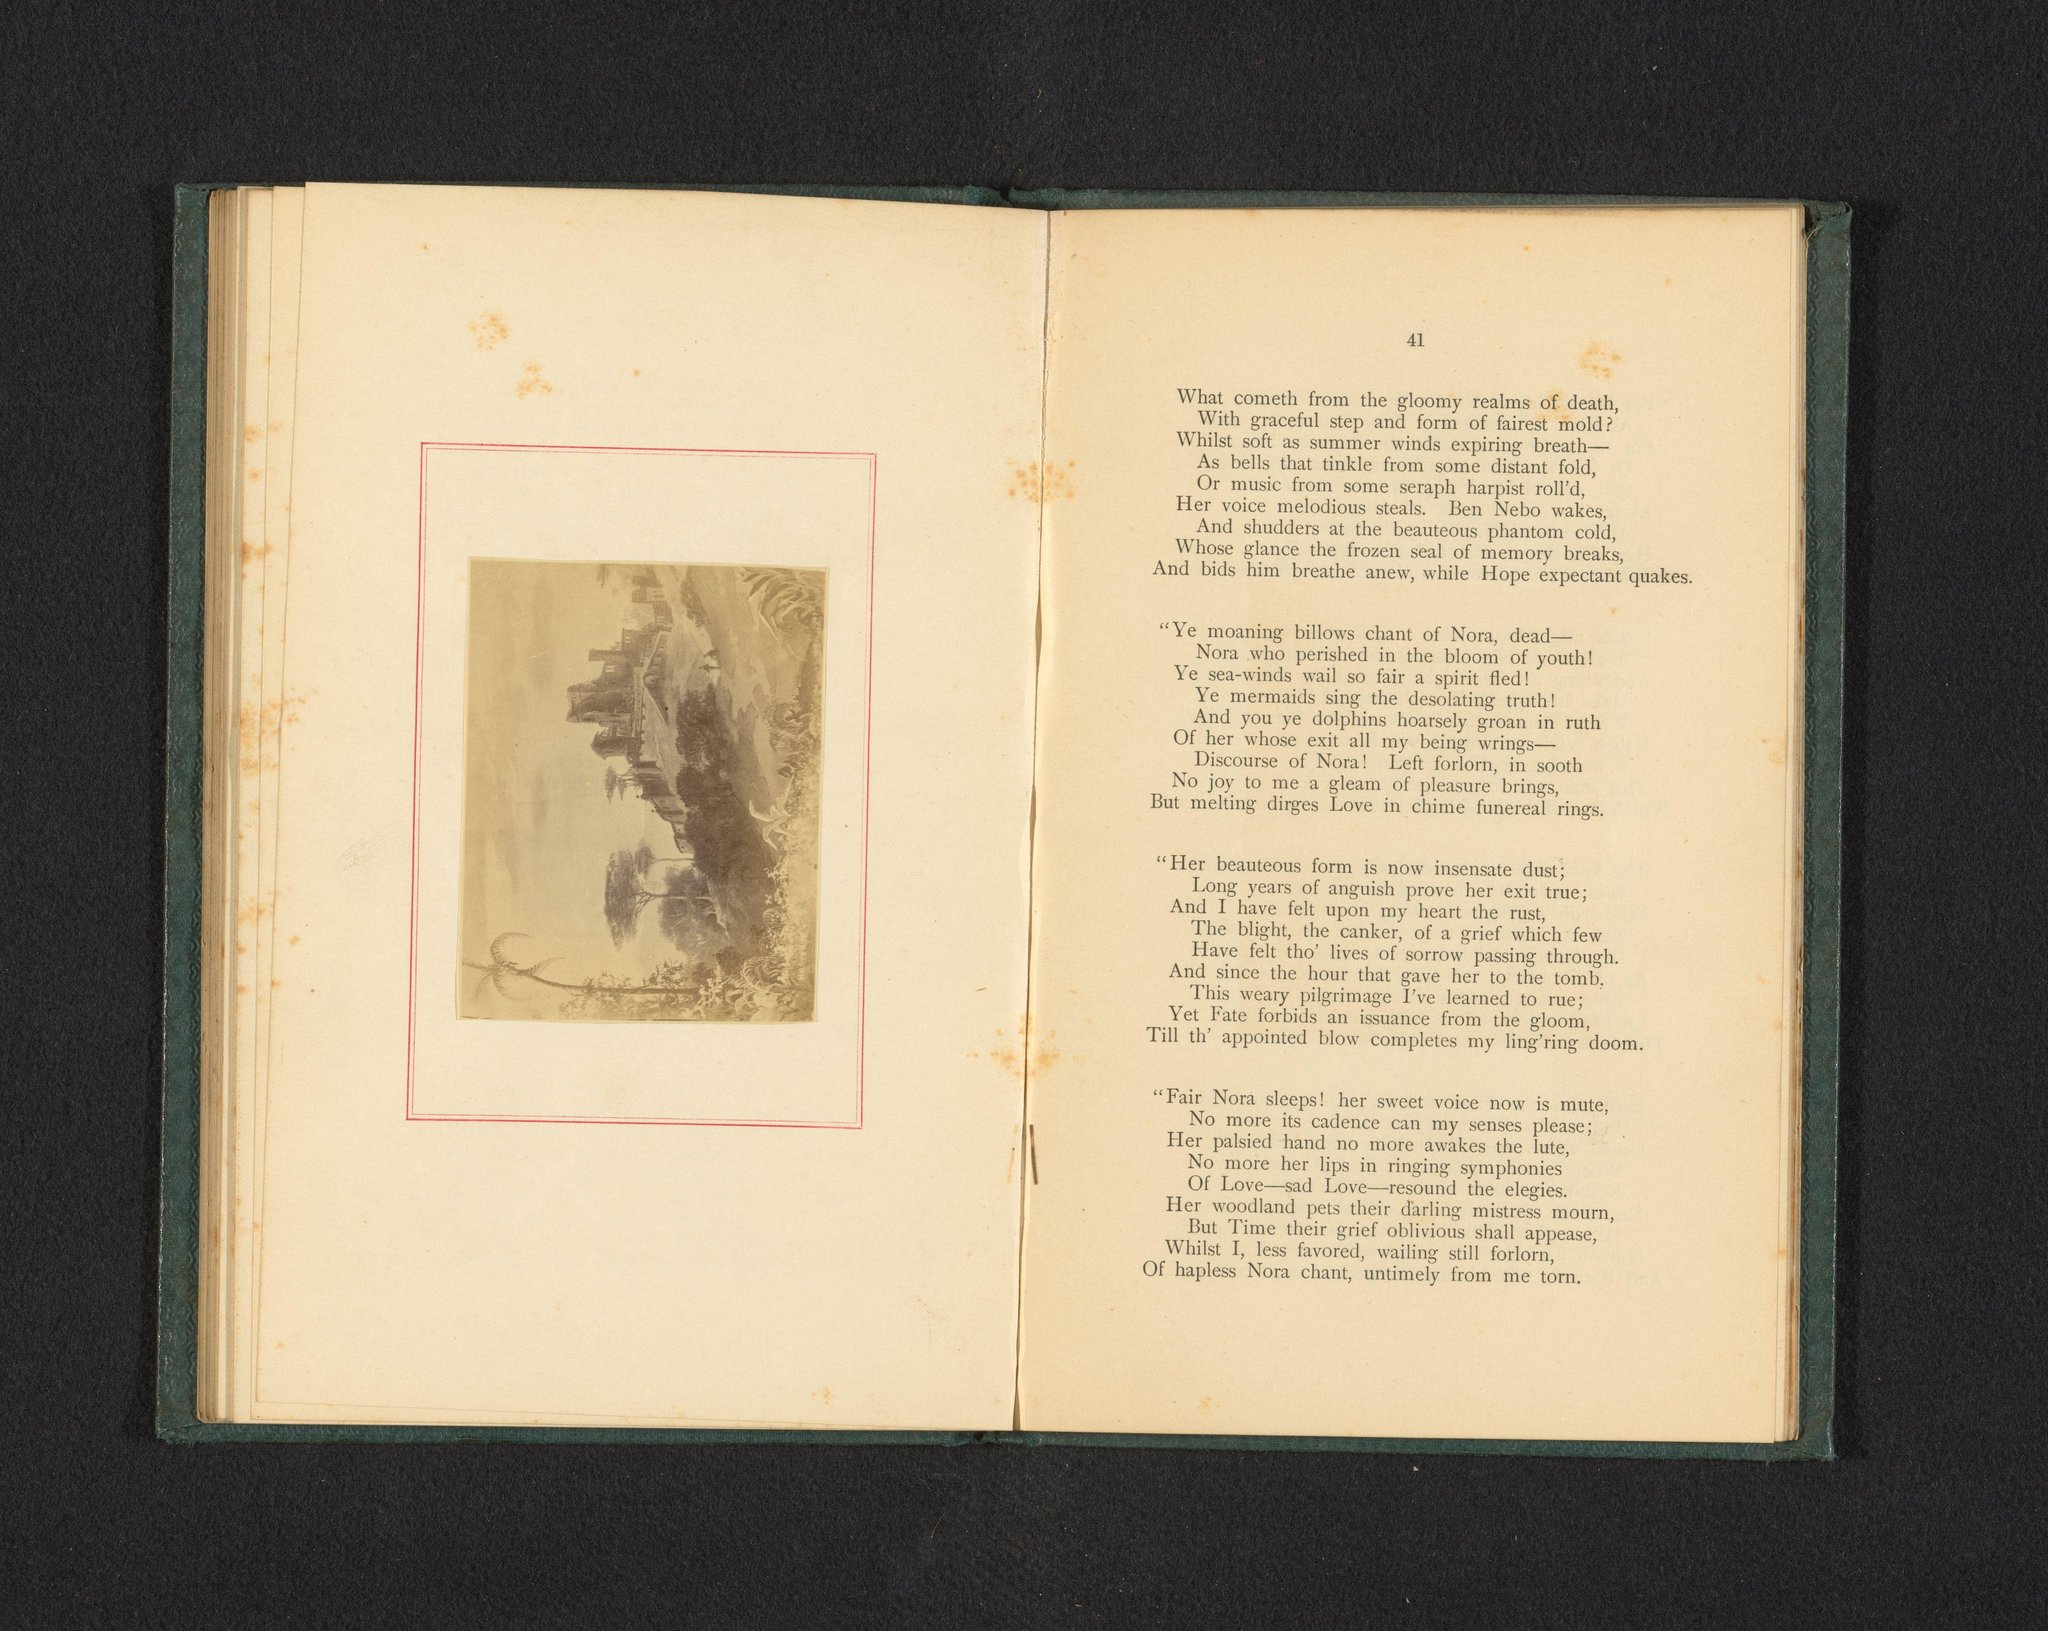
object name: page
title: Fotoreproductie van een schilderij, voorstellende een gezicht op (vermoedelijk) een paleis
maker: flaglor and perkins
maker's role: fotograaf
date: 1866-1871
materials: photographic support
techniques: albumen print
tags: palace, façade (of house or building)